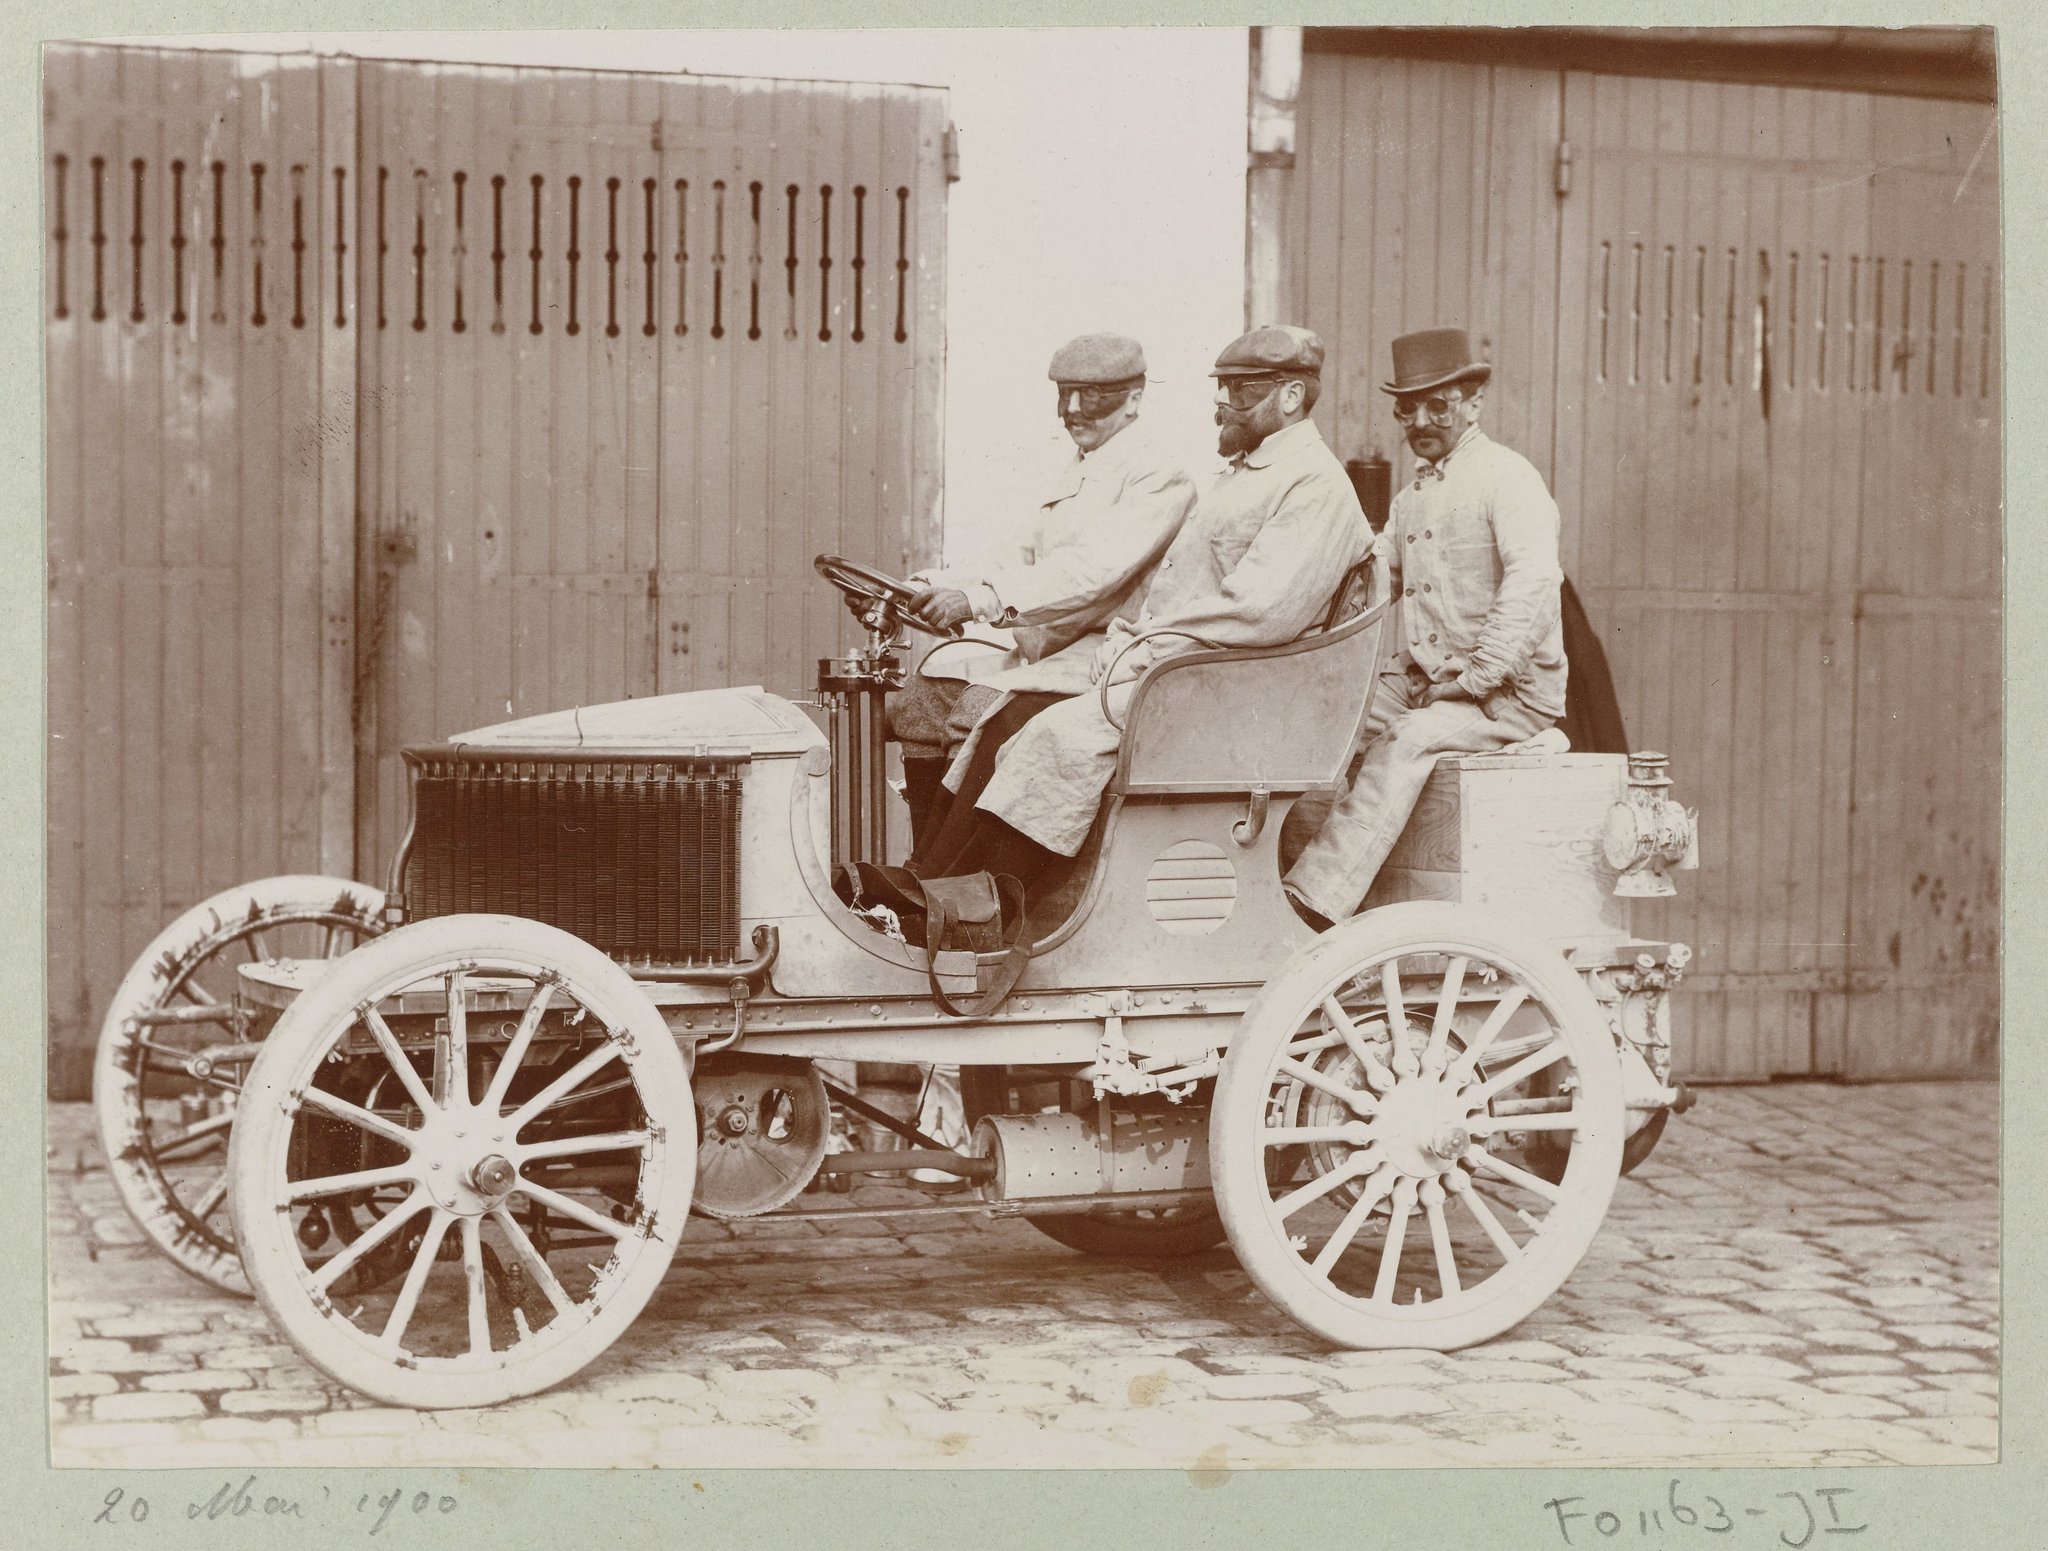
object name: photograph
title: Drie mannen met stofbrillen in een automobiel, vermoedelijk in Frankrijk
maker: delizy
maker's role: manufacturer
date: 1900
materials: paper, photographic support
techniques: gelatin silver print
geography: france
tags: automobile, france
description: Onderdeel van Fotoalbum van een Franse amateurfotograaf met opnames van uitstapjes in Frankrijk, Spanje, België, Luxemburg en Nederland, de eerste automobielen en autoraces.